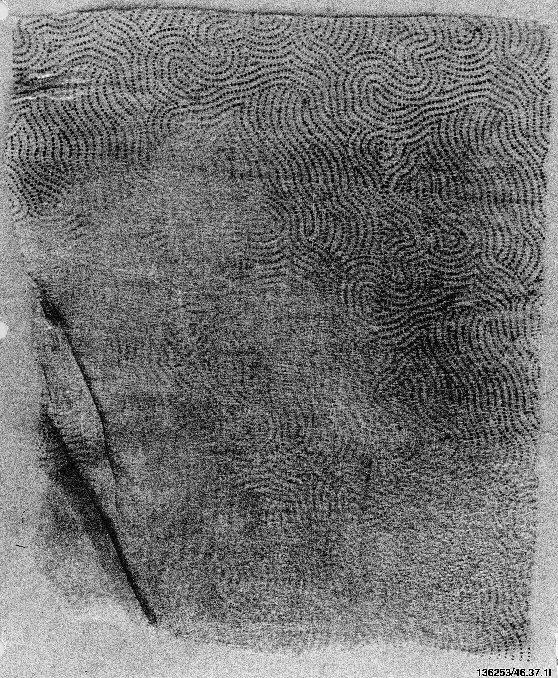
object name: turban fragment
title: Fragment of Turban Cloth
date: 1701-1800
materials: cotton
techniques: printing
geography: bangladesh